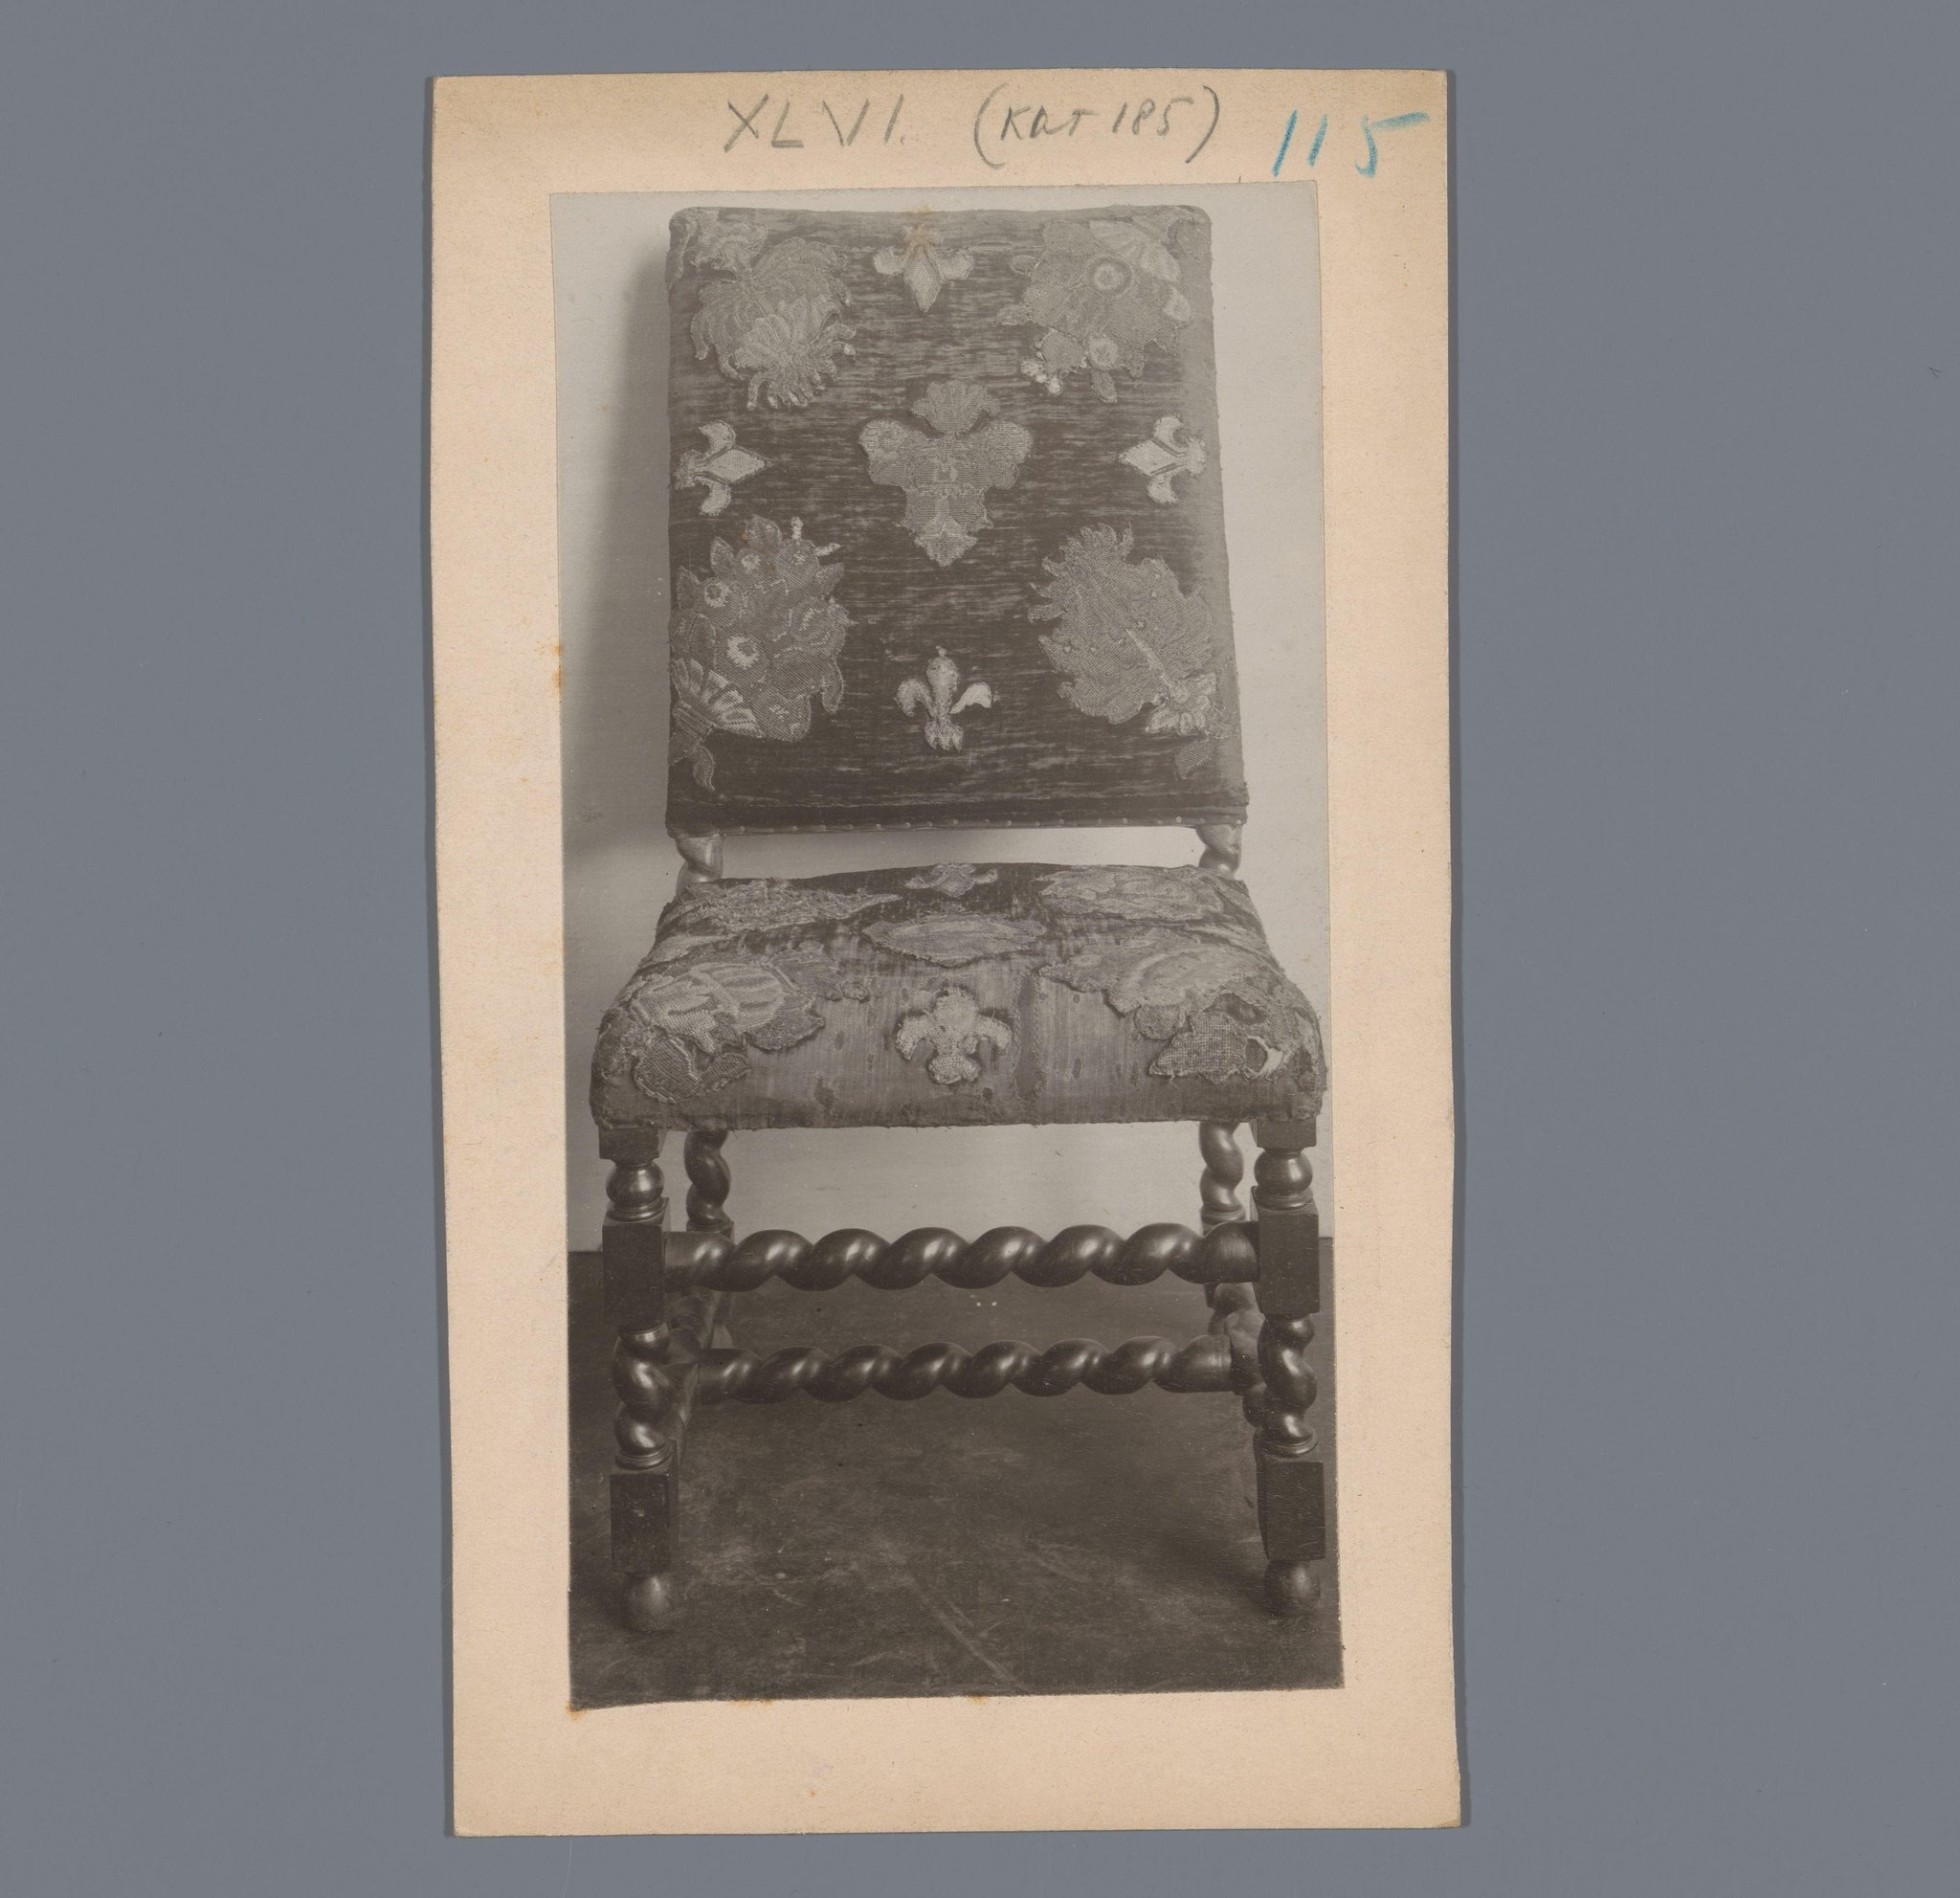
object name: photograph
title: Stoel met gedraaide poten (vermoedelijk) in het Rijksmuseum te Amsterdam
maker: Anonymous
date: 1875-1900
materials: photographic support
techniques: matte daylight collodion silver print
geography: amsterdam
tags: chair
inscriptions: collector's mark: ‘Kunstnijverheidschool Quellinus Amsterdam Frans Halsstraat 14.’, collector's mark: ‘Instituut voor kunst-nijverheidsonderwijs Gabriël Metsustraat No. 16, Amsterdam’, number: ‘XLVI (Kat 185) 115’